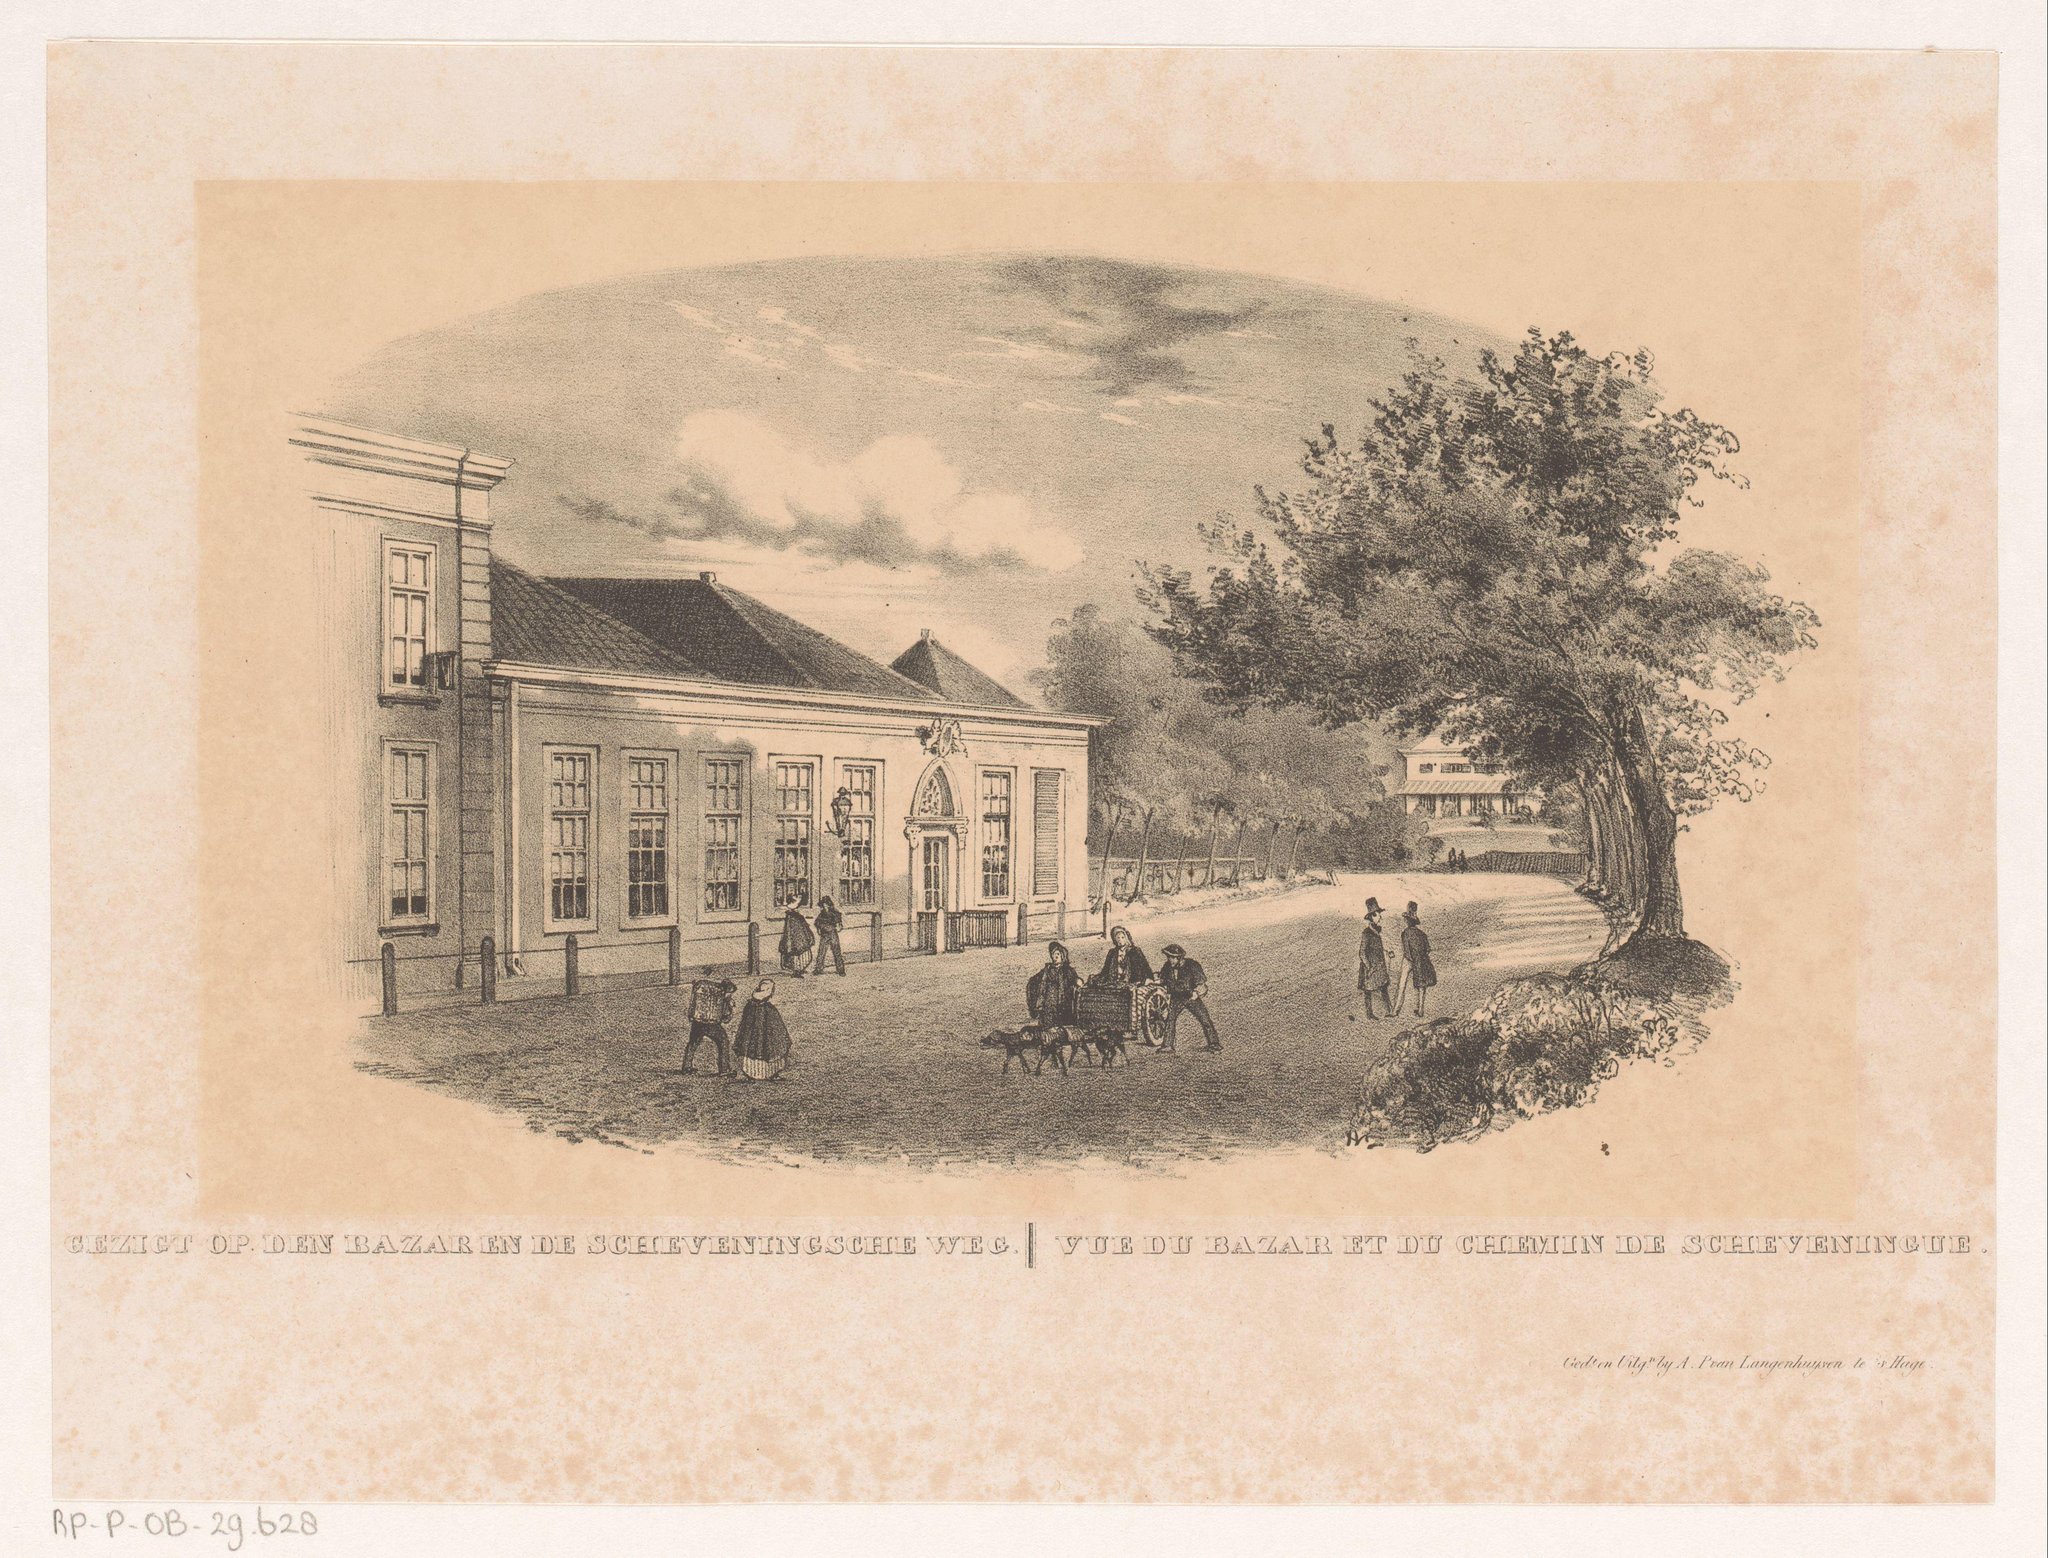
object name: print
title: Groote Koninklijke Bazar te Den Haag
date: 1830-1846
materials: paper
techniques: tone lithography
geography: the hague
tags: shop, store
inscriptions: collector's mark: Lugt 2228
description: De Groote Koninklijke Bazar, een van de eerste warenhuizen in Nederland, gelegen aan de huidige Zeestraat. Op straat lopen mensen.